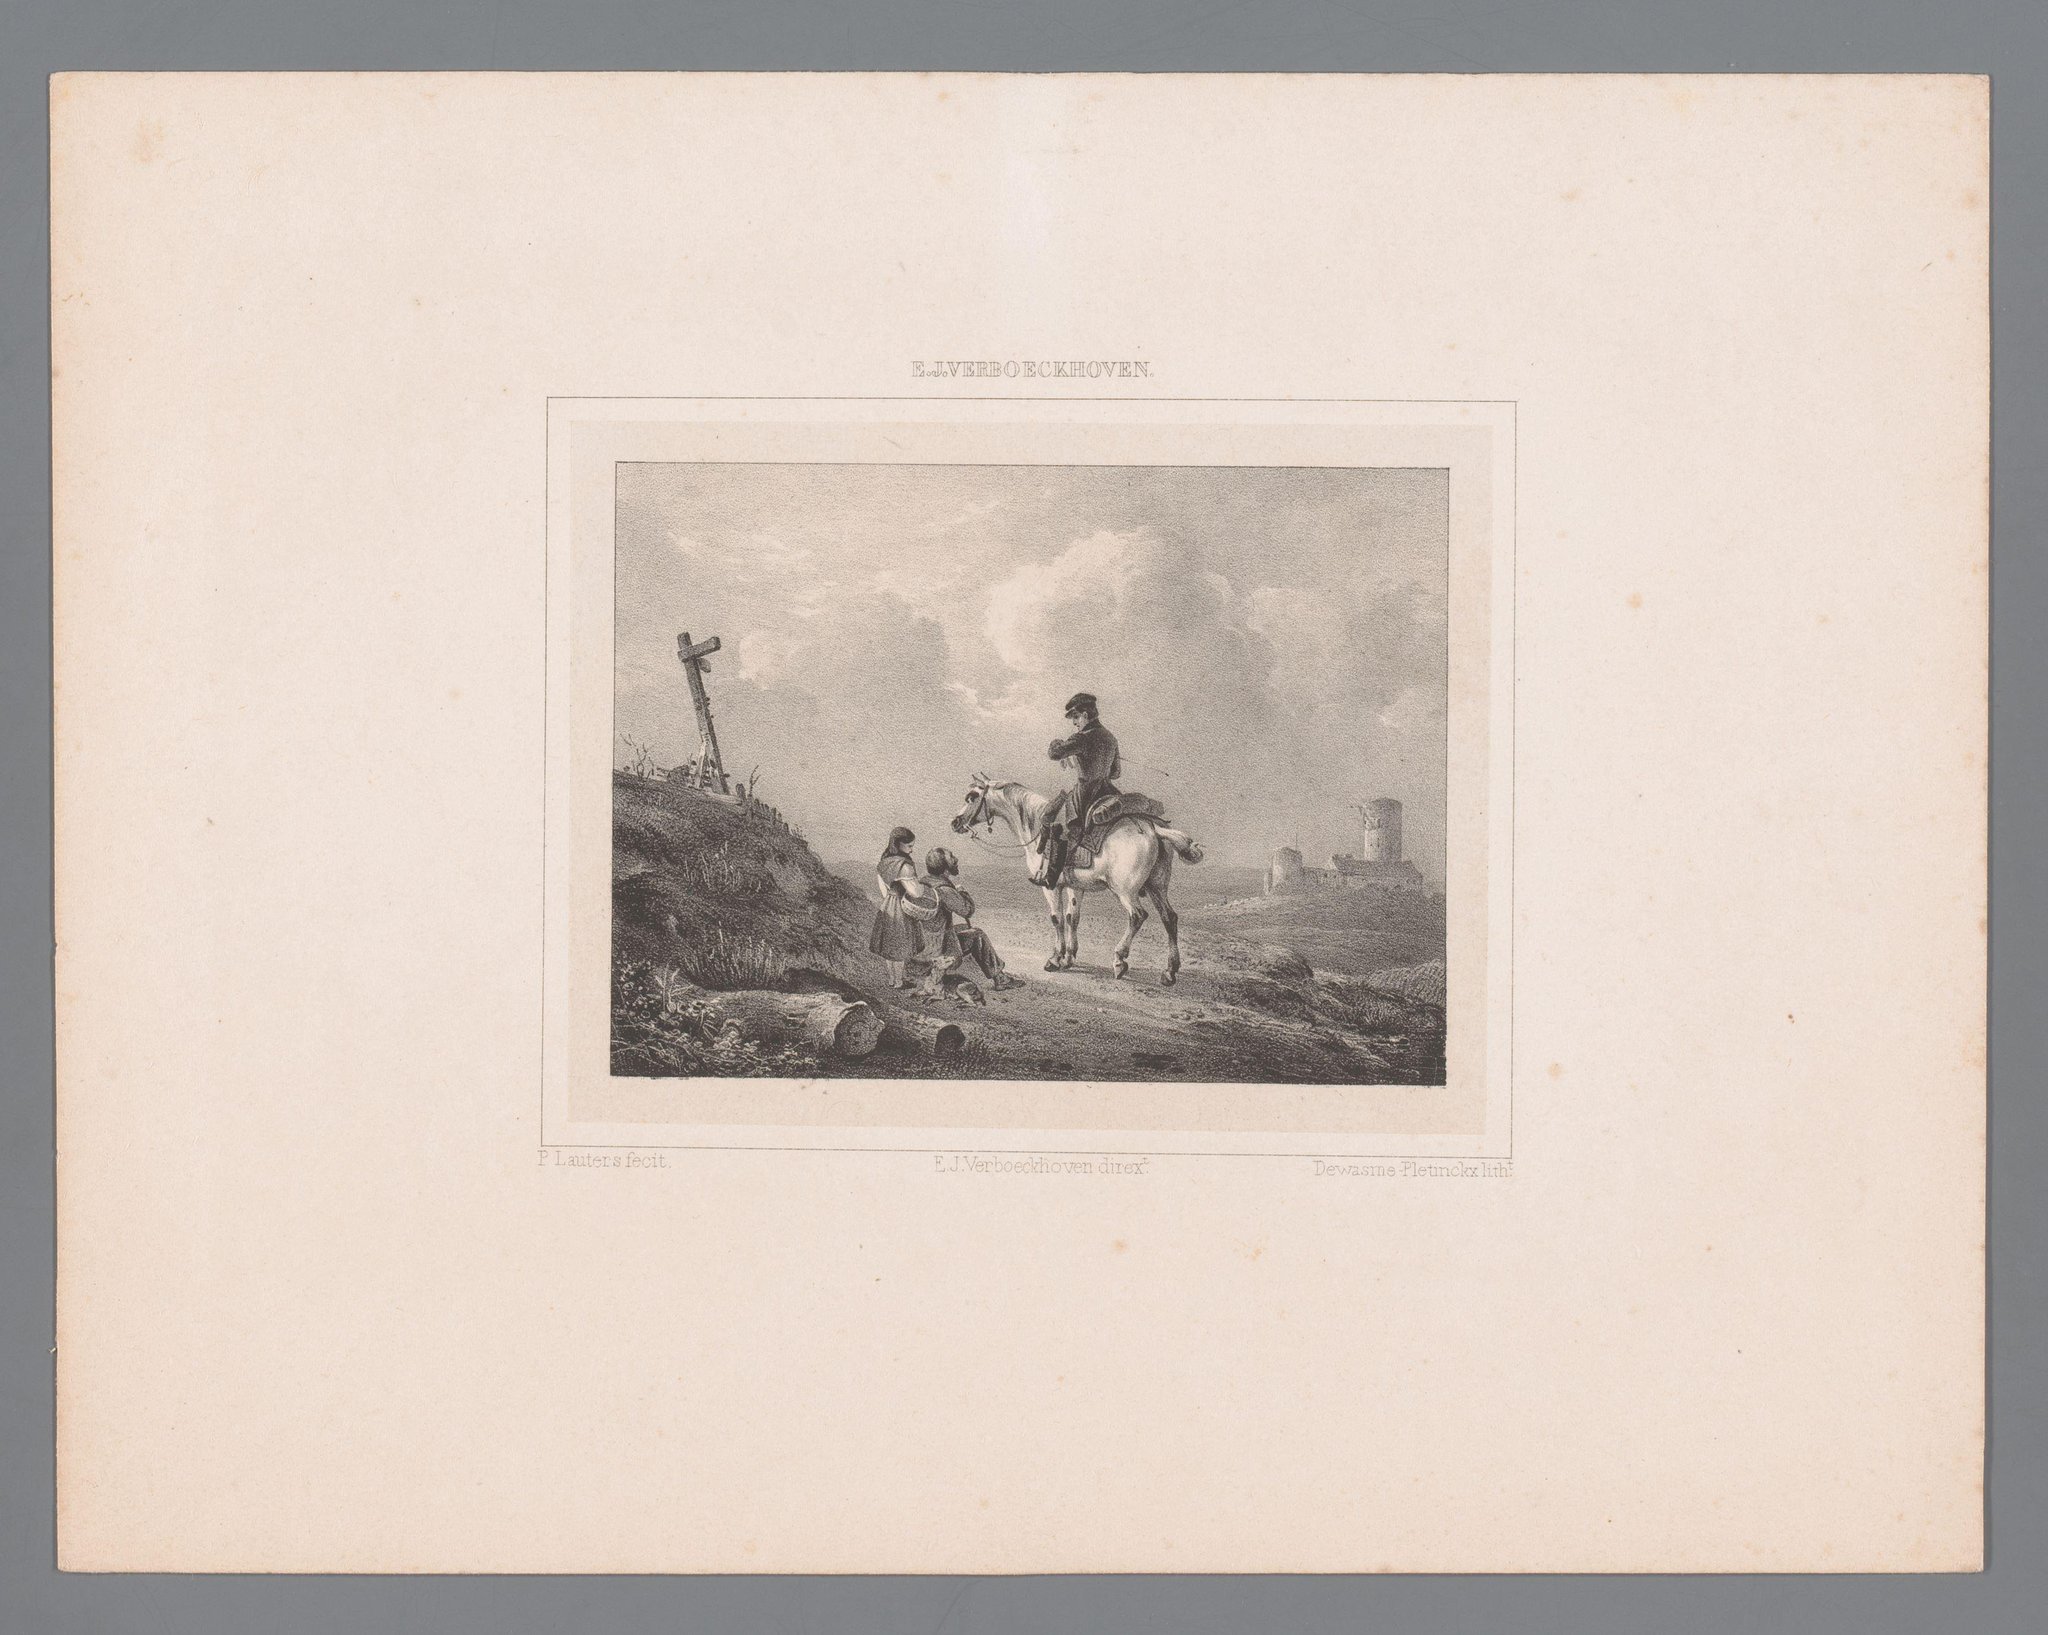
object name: print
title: Ruiter aangesproken door een bedelaar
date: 1829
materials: paper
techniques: lithograph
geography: brussels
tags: riding a horse, ass, or mule; rider, horseman, beggar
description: Prent verschenen in: Verboeckhoven, Eugène. Album lithographié par Paul Lauters d'après les dessins des principaux peintres du Royaume des Pays-Bas. Brussel: Antoine Dewasme-Pletinckx, 1829.